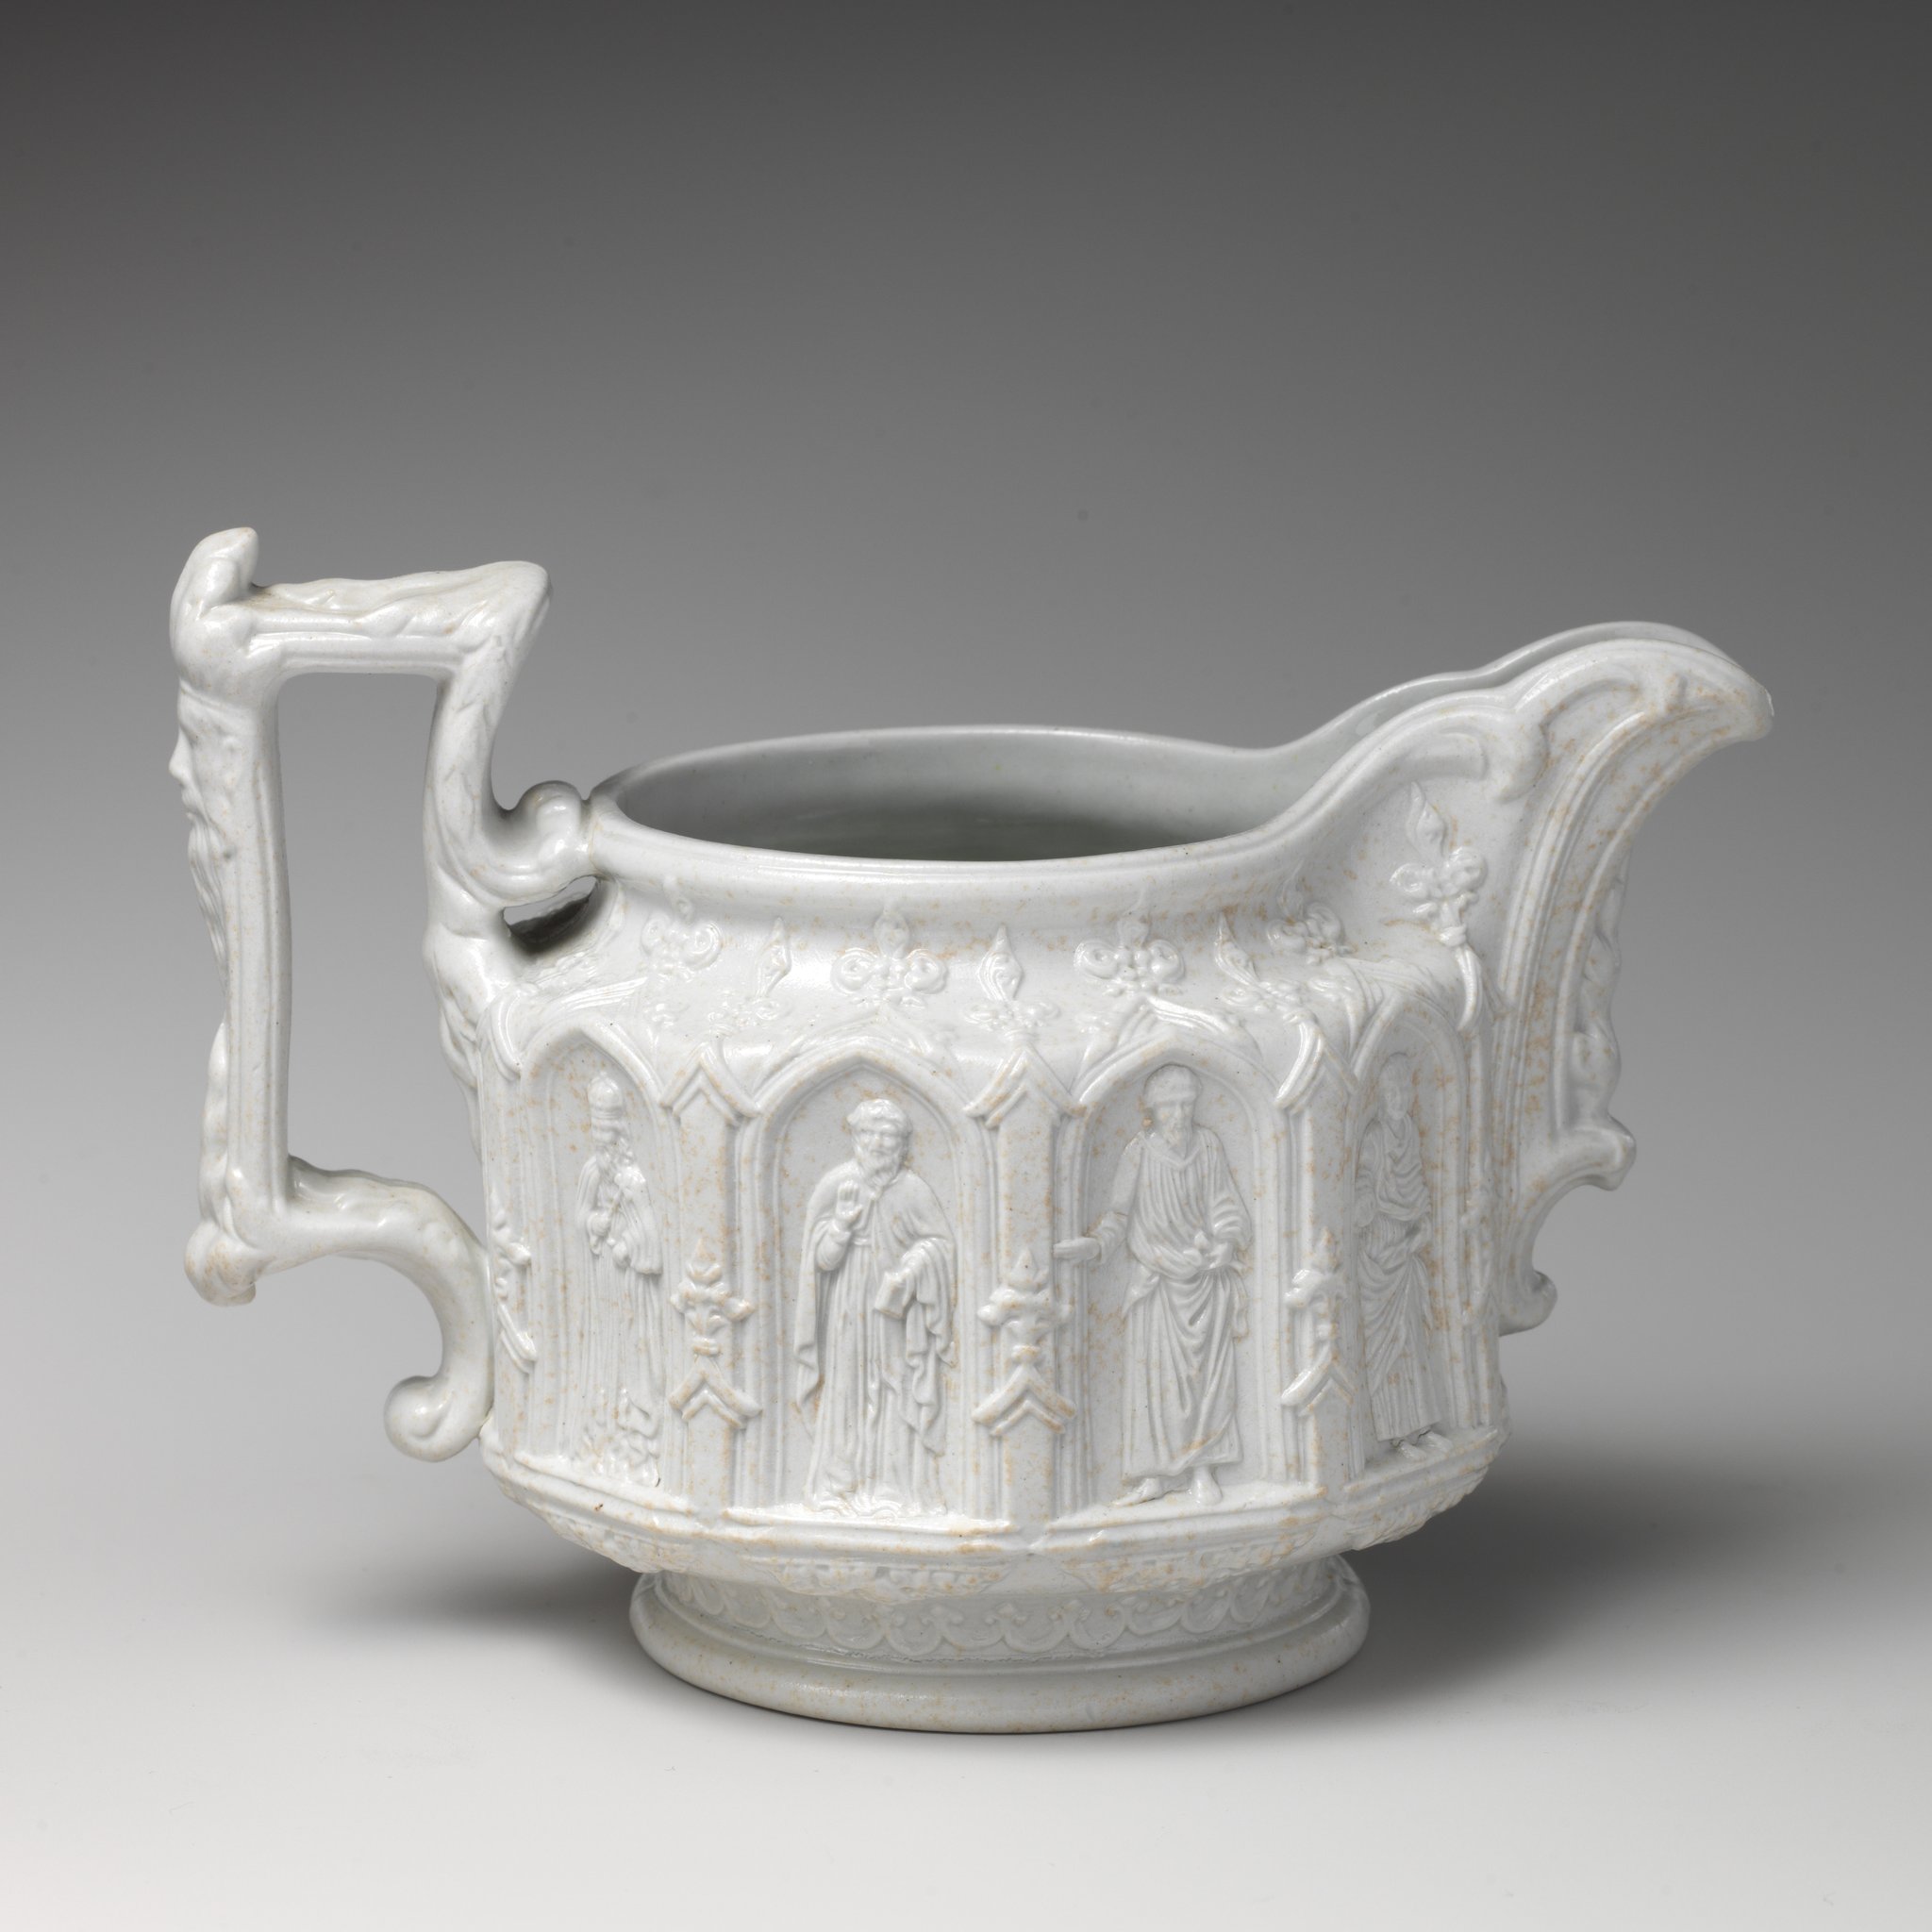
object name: milk jug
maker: charles meigh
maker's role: designer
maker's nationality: british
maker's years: 1835-1861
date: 1842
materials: stoneware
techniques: glazing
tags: men